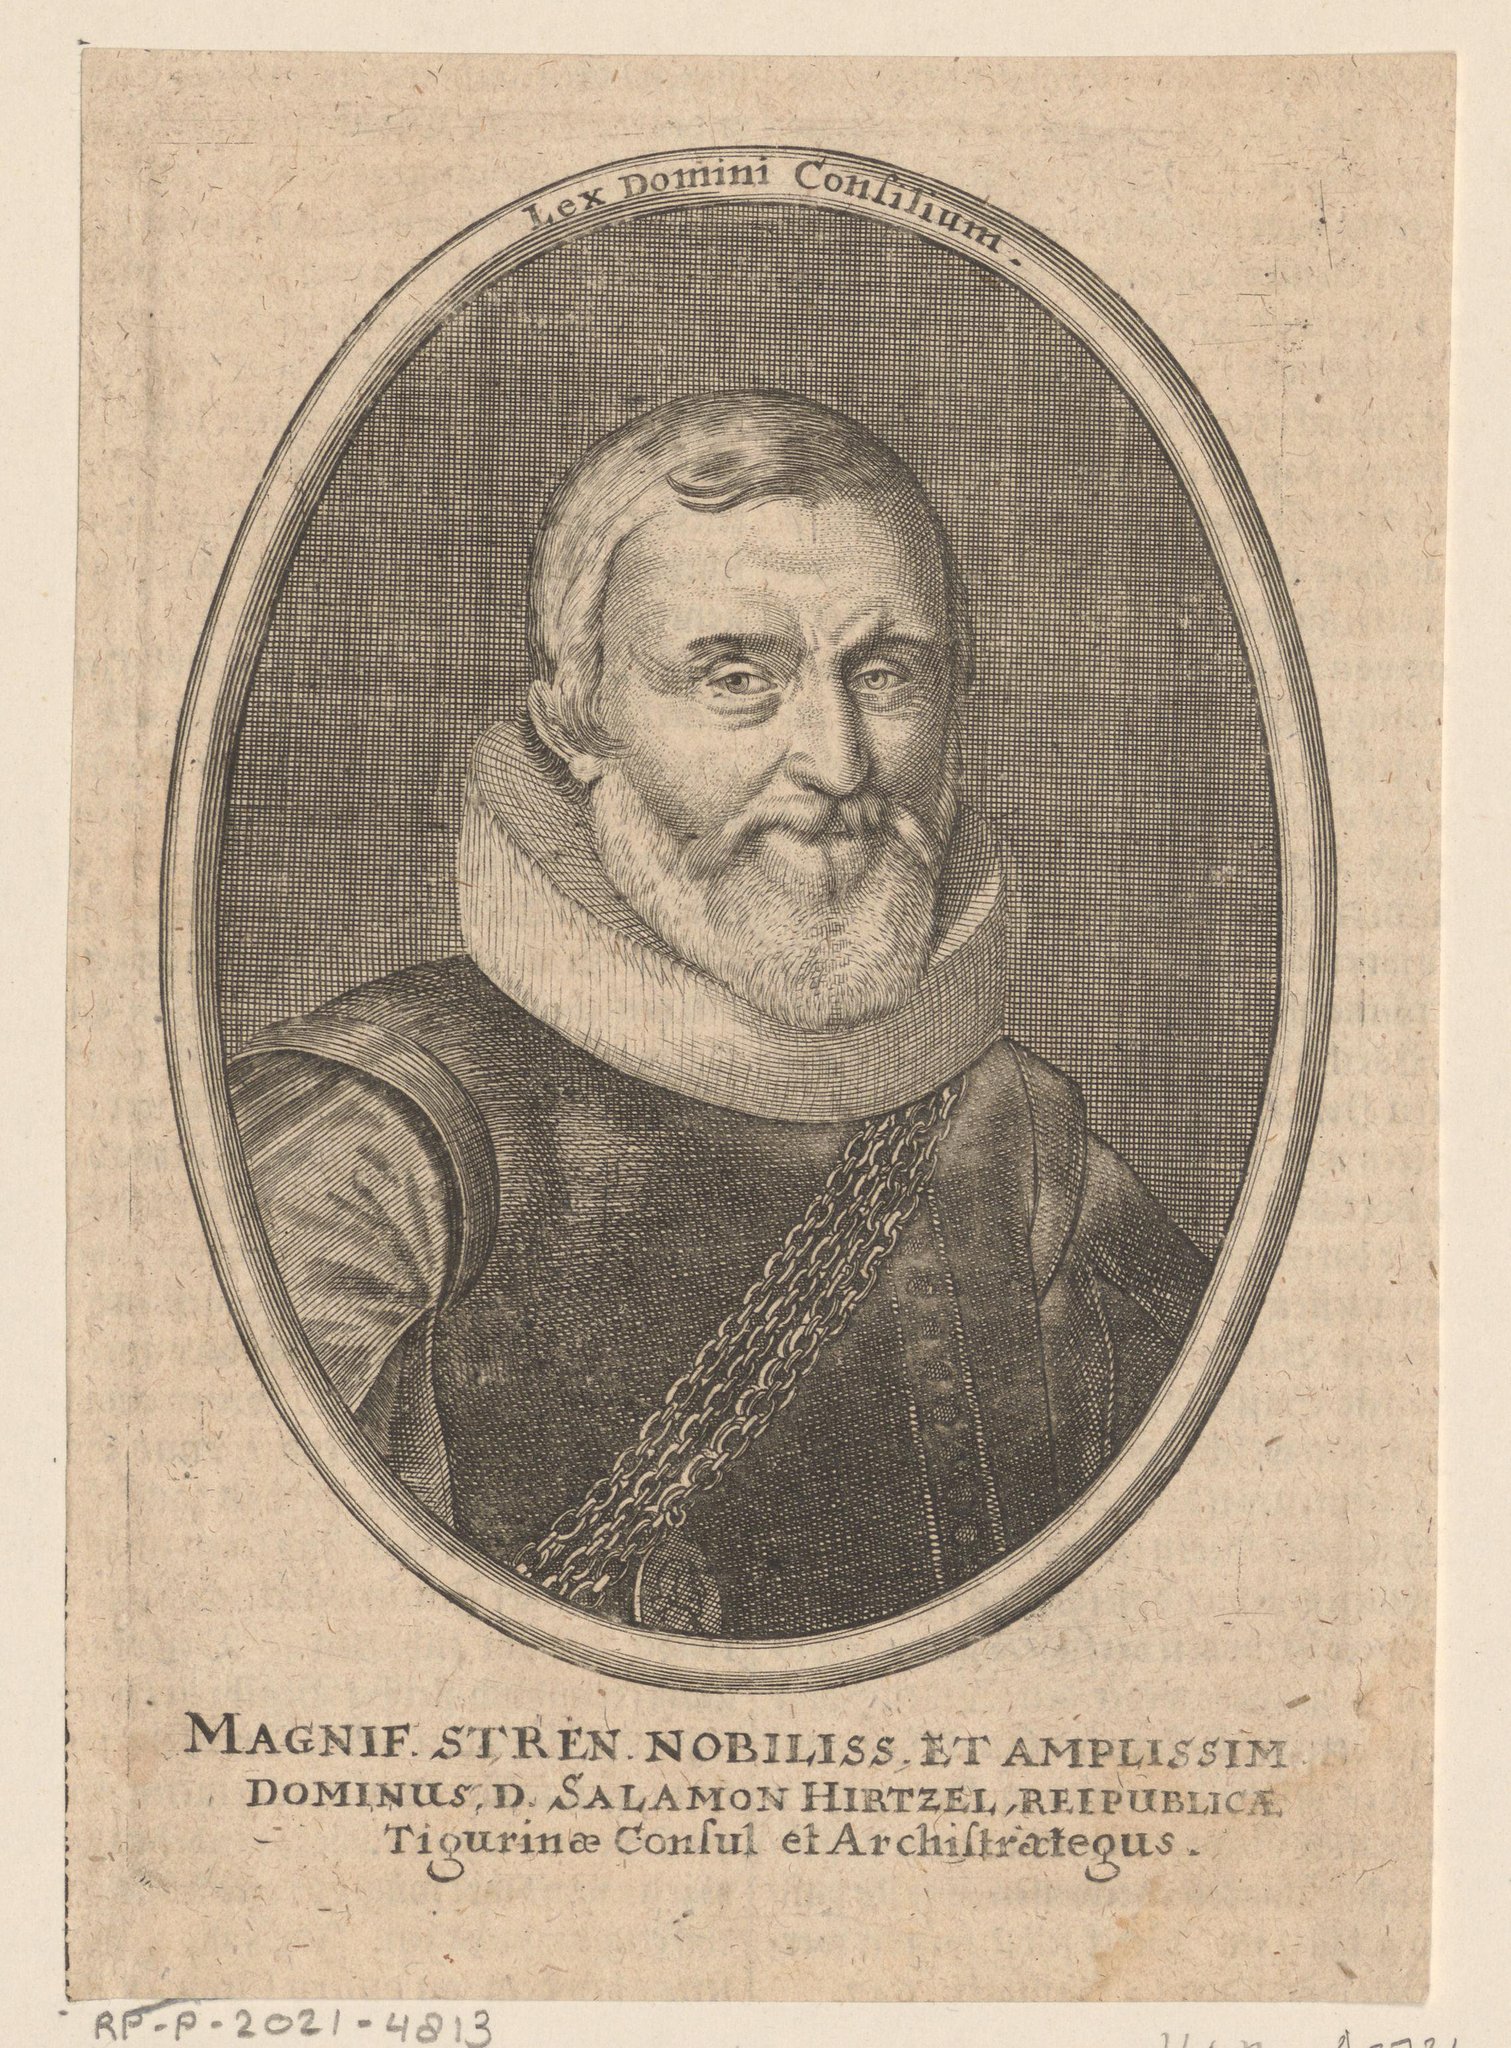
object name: print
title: Portret van Salomon Hirzel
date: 1647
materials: paper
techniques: engraving, letterpress printing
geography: frankfurt am main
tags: mayor, mayor, burgomaster, historical persons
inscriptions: date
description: Prent uit: Theatrum Europaeum. Frankfurt am Main: Matthäus Merian I, 1647, dl. 5.